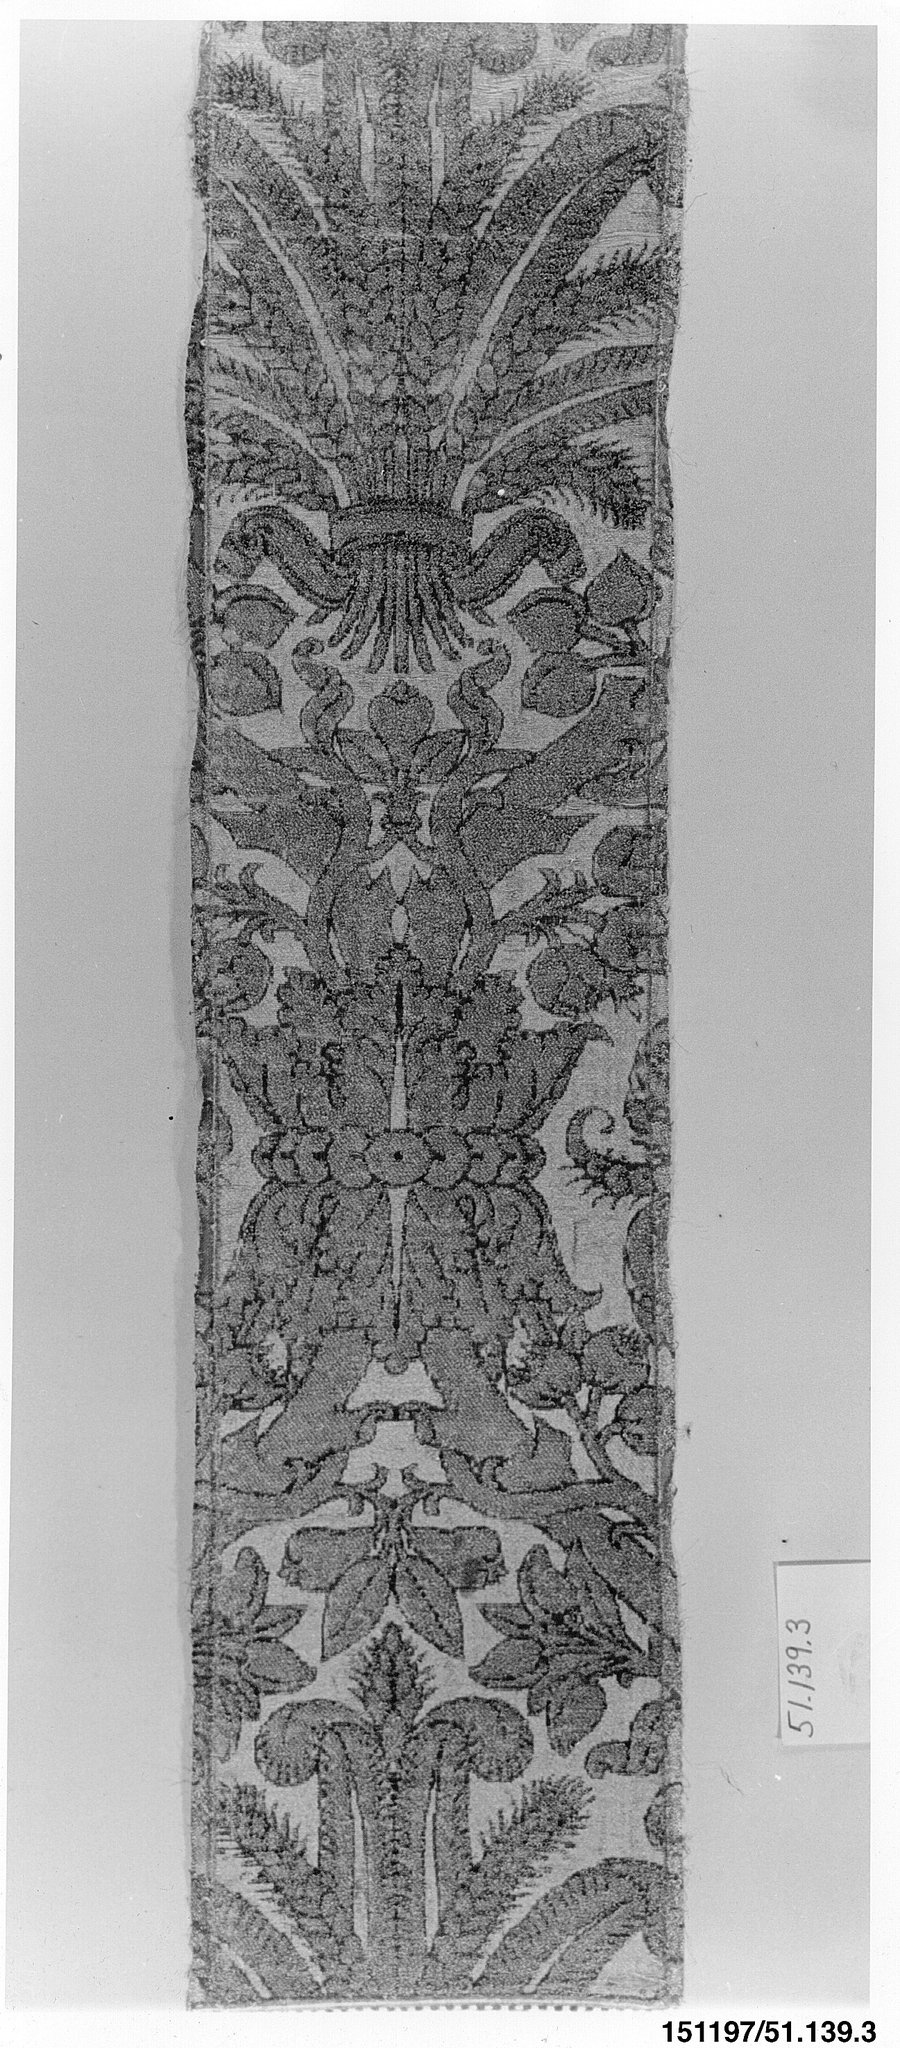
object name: piece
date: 1401-1500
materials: metal thread, silk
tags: leaves